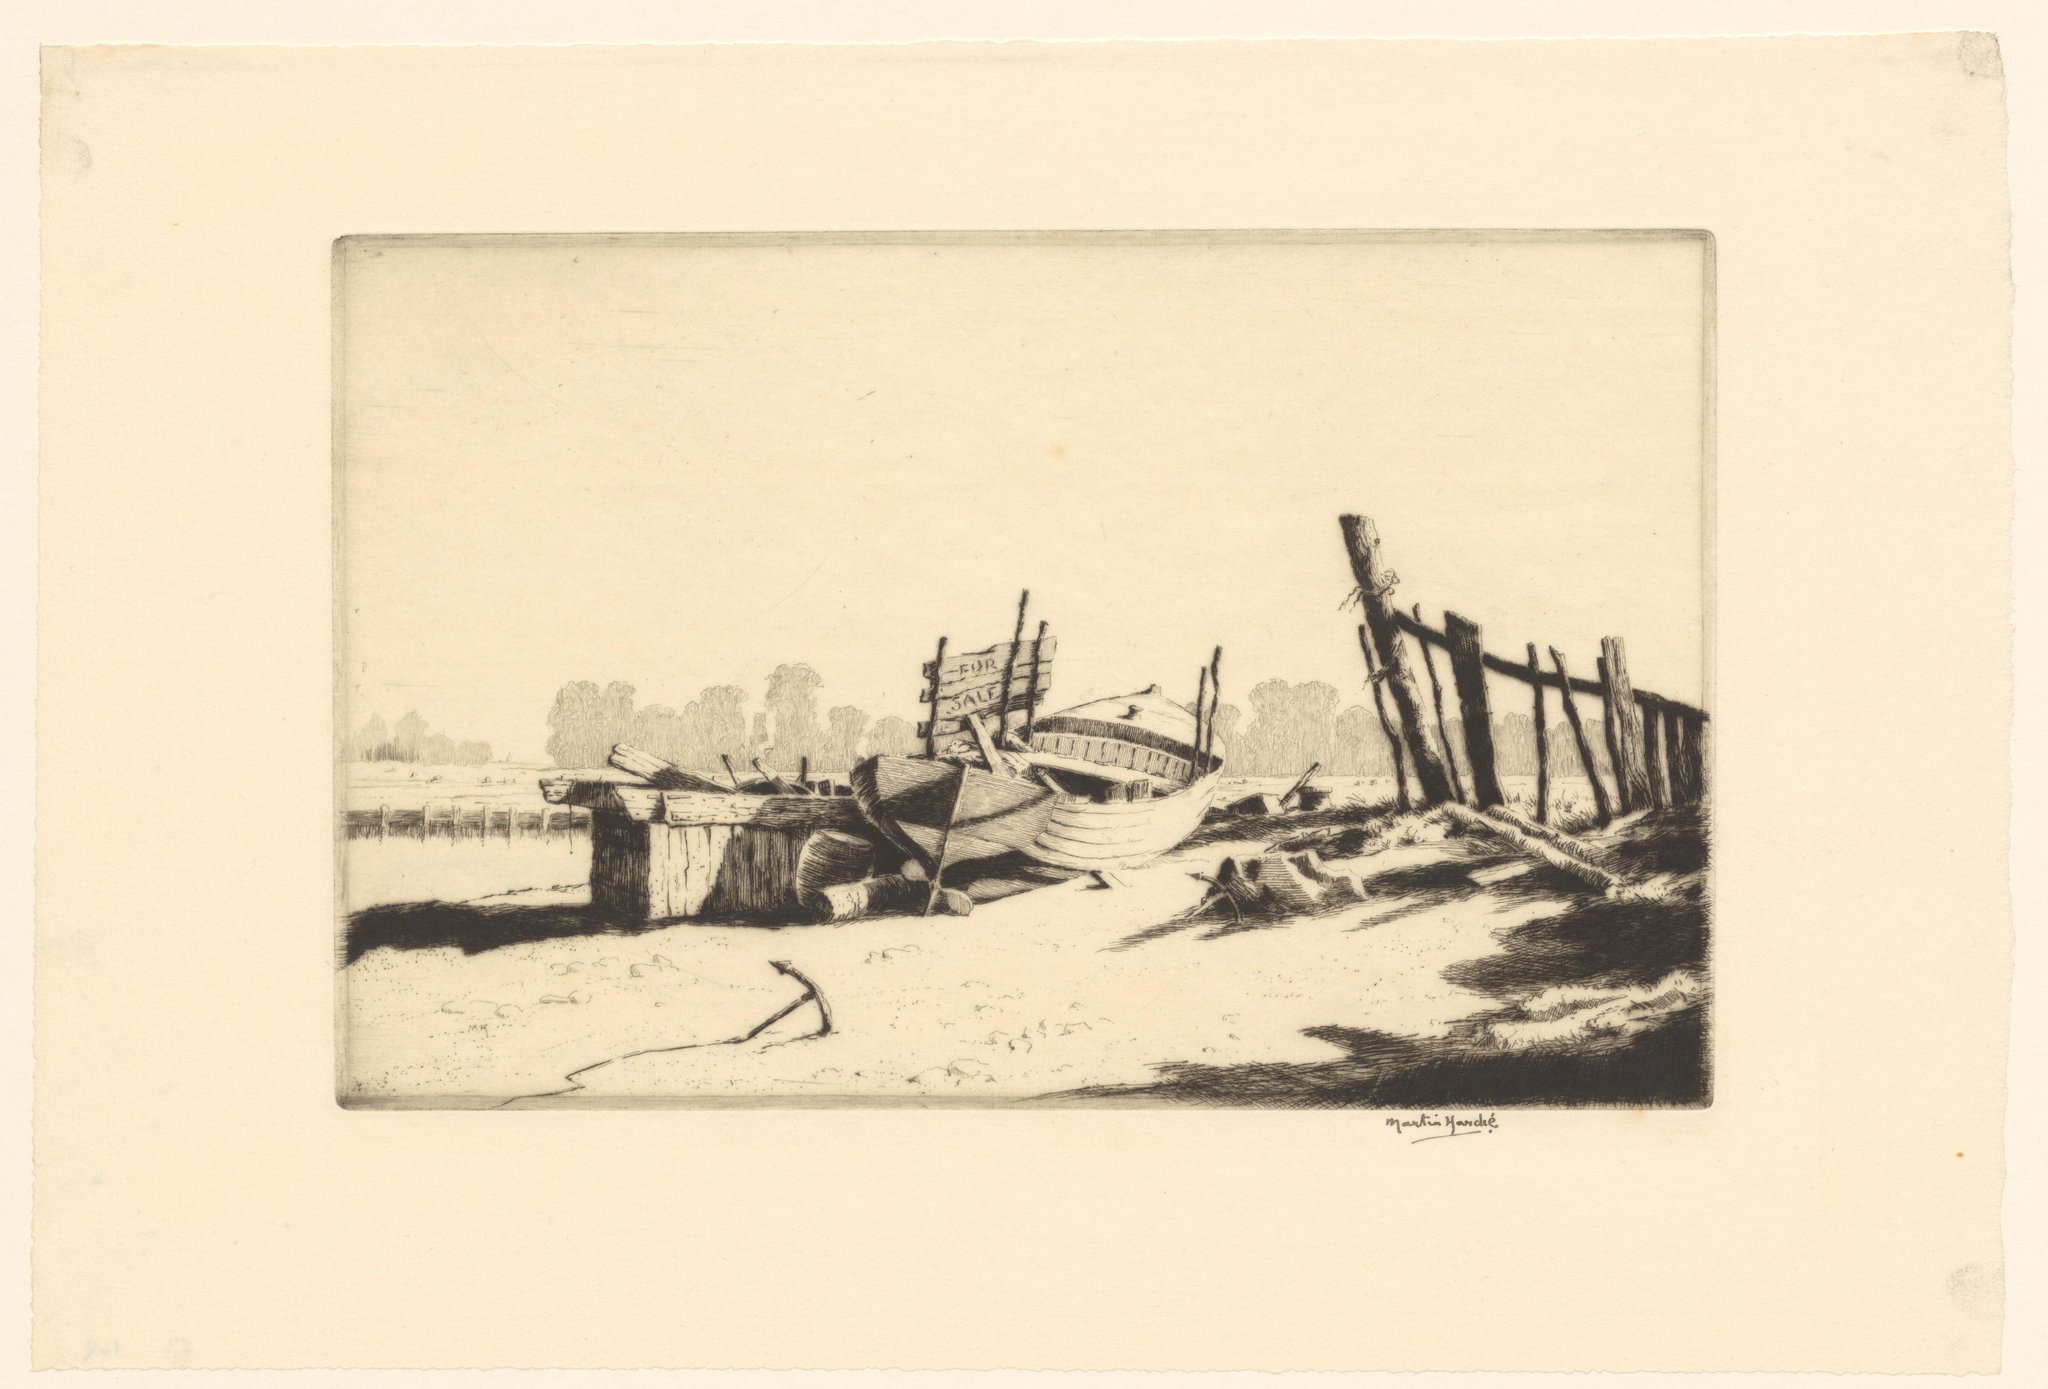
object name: print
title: 'For Sale', Orford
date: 1940-1945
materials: paper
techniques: drypoint, etching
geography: orford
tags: boat propelled by man or animal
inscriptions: annotation: ‘Martin Hardie’, collector's mark: Lugt 2760, collector's mark: Lugt 2228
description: Op het houten bord bij de boot staat tekst in het Engels: 'For Sale'.